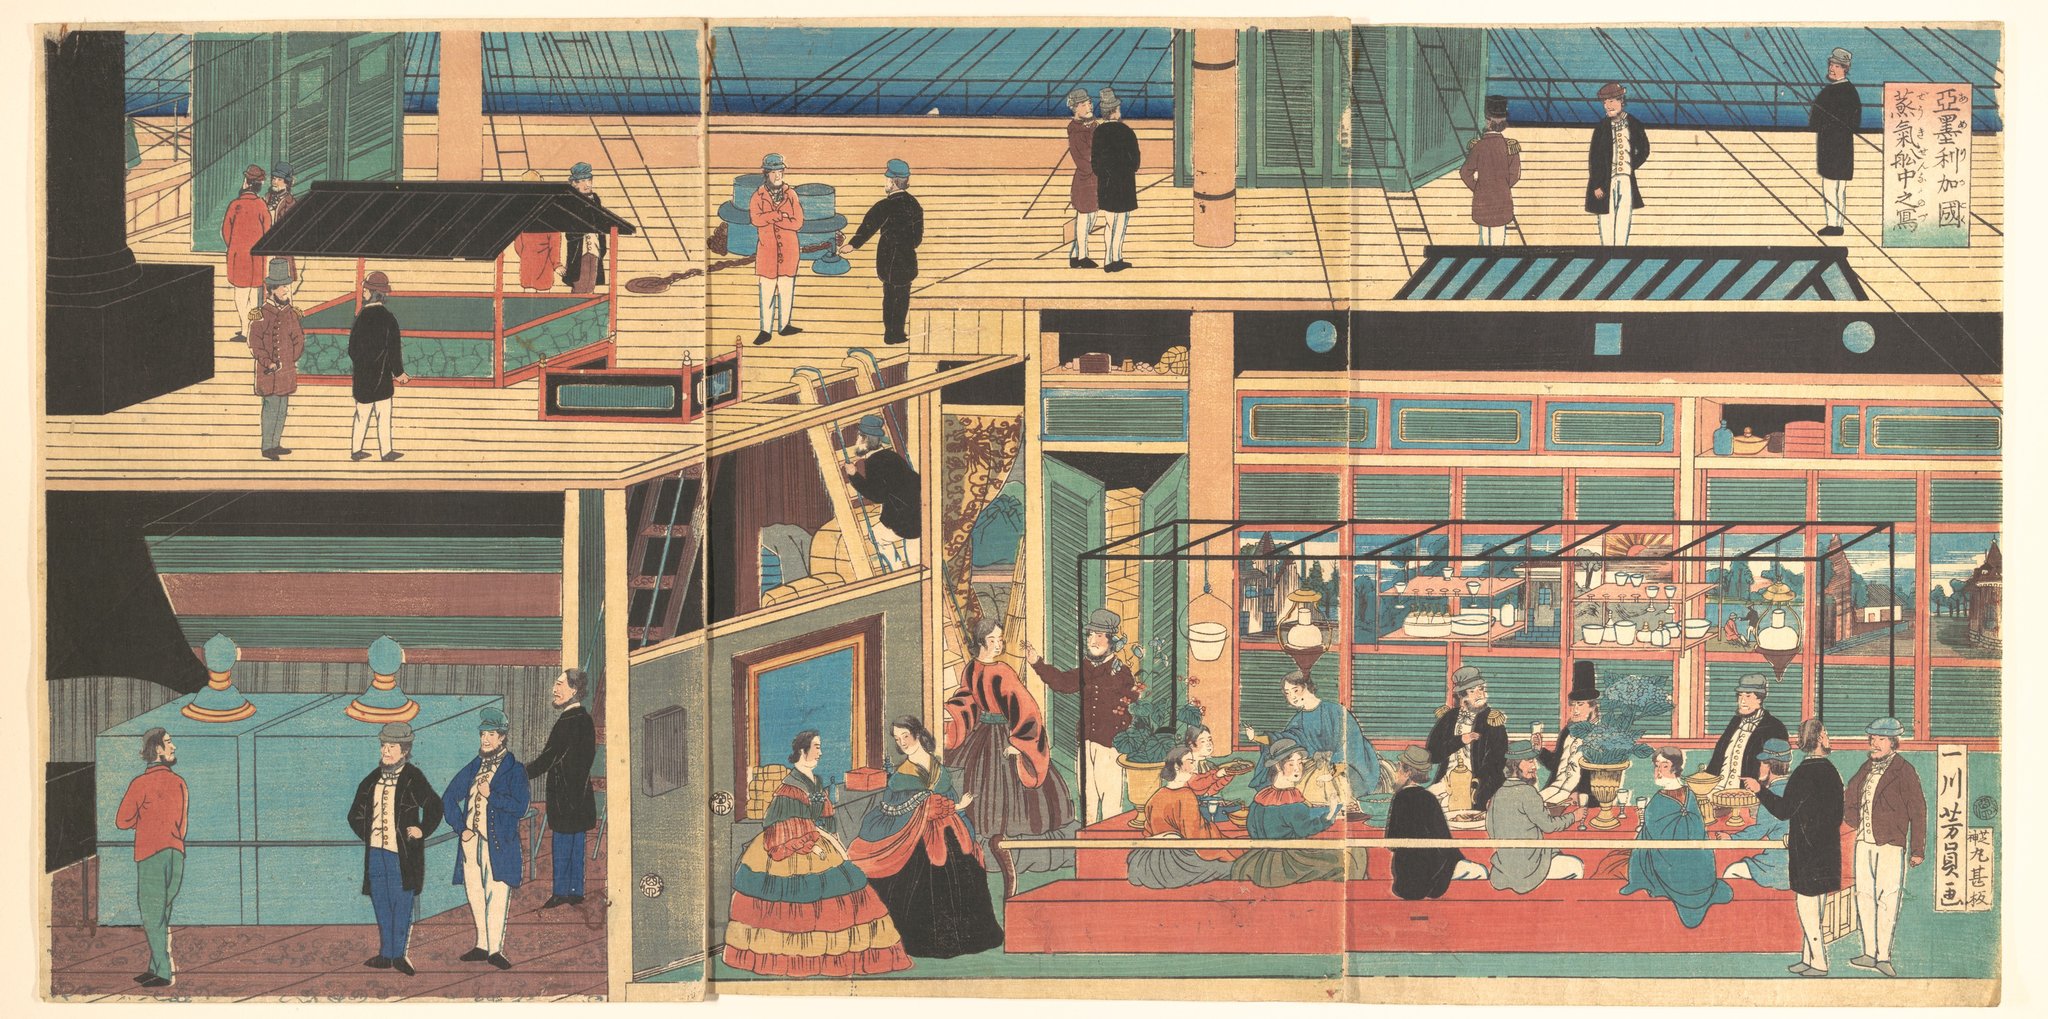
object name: print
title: Interior of an American Steamship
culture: japanese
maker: utagawa yoshikazu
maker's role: artist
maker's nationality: japanese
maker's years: 1845-1870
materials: ink, paper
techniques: woodblock print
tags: men,women,ships